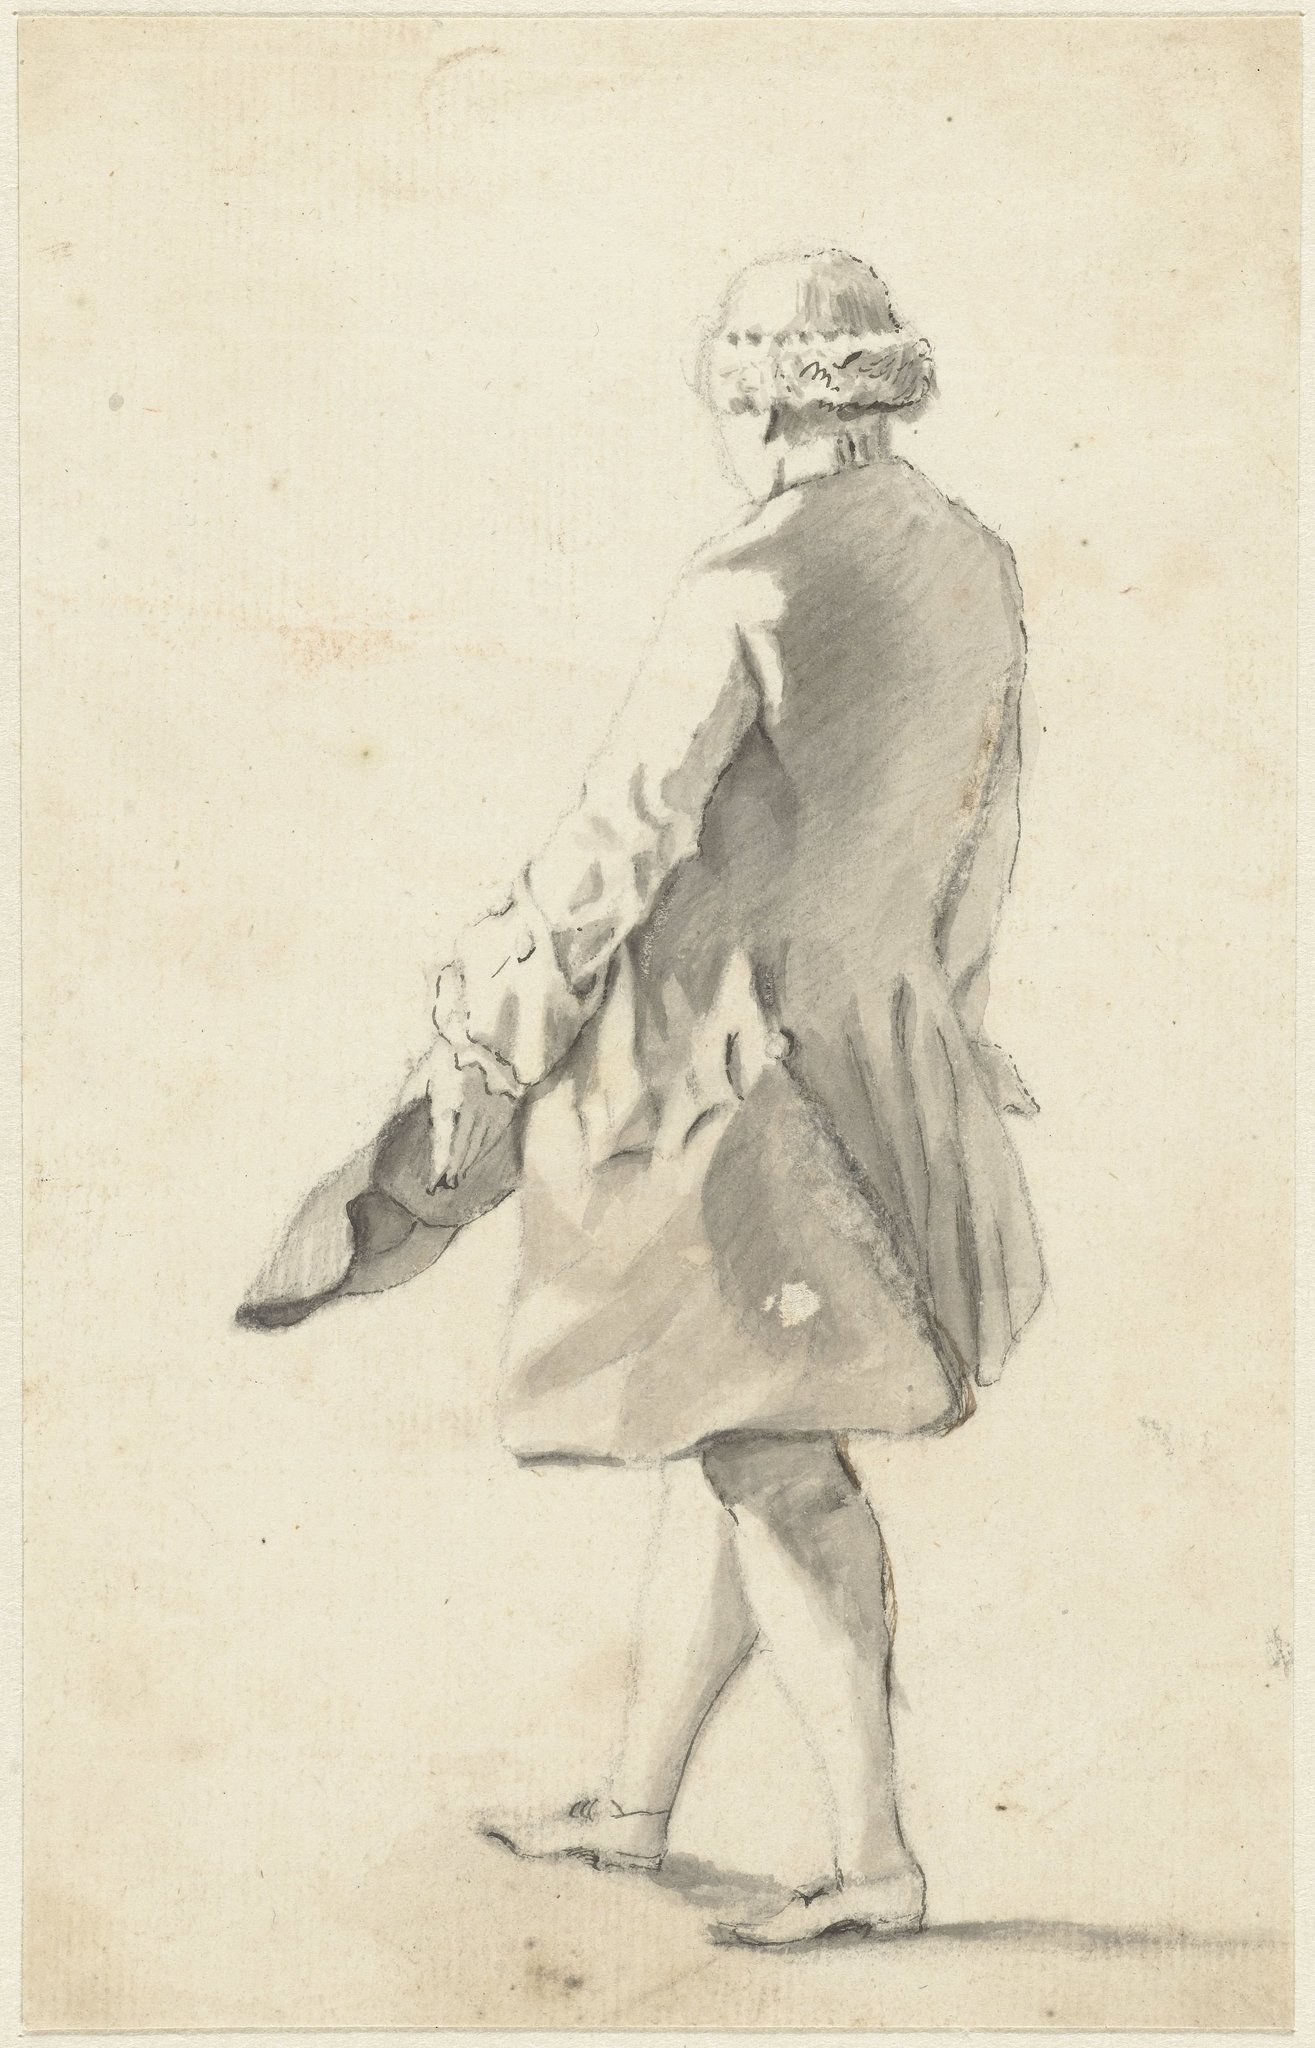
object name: drawing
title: Figuurstudie van een op de rug geziene staande man met zijn steek in de linkerhand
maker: Anonymous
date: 1775-1799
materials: ink, paper, pencil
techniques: brush, pen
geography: northern netherlands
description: Behoort tot groep figuurstudies door Simon Fokke, maar kan niet aan hem worden toegeschreven.